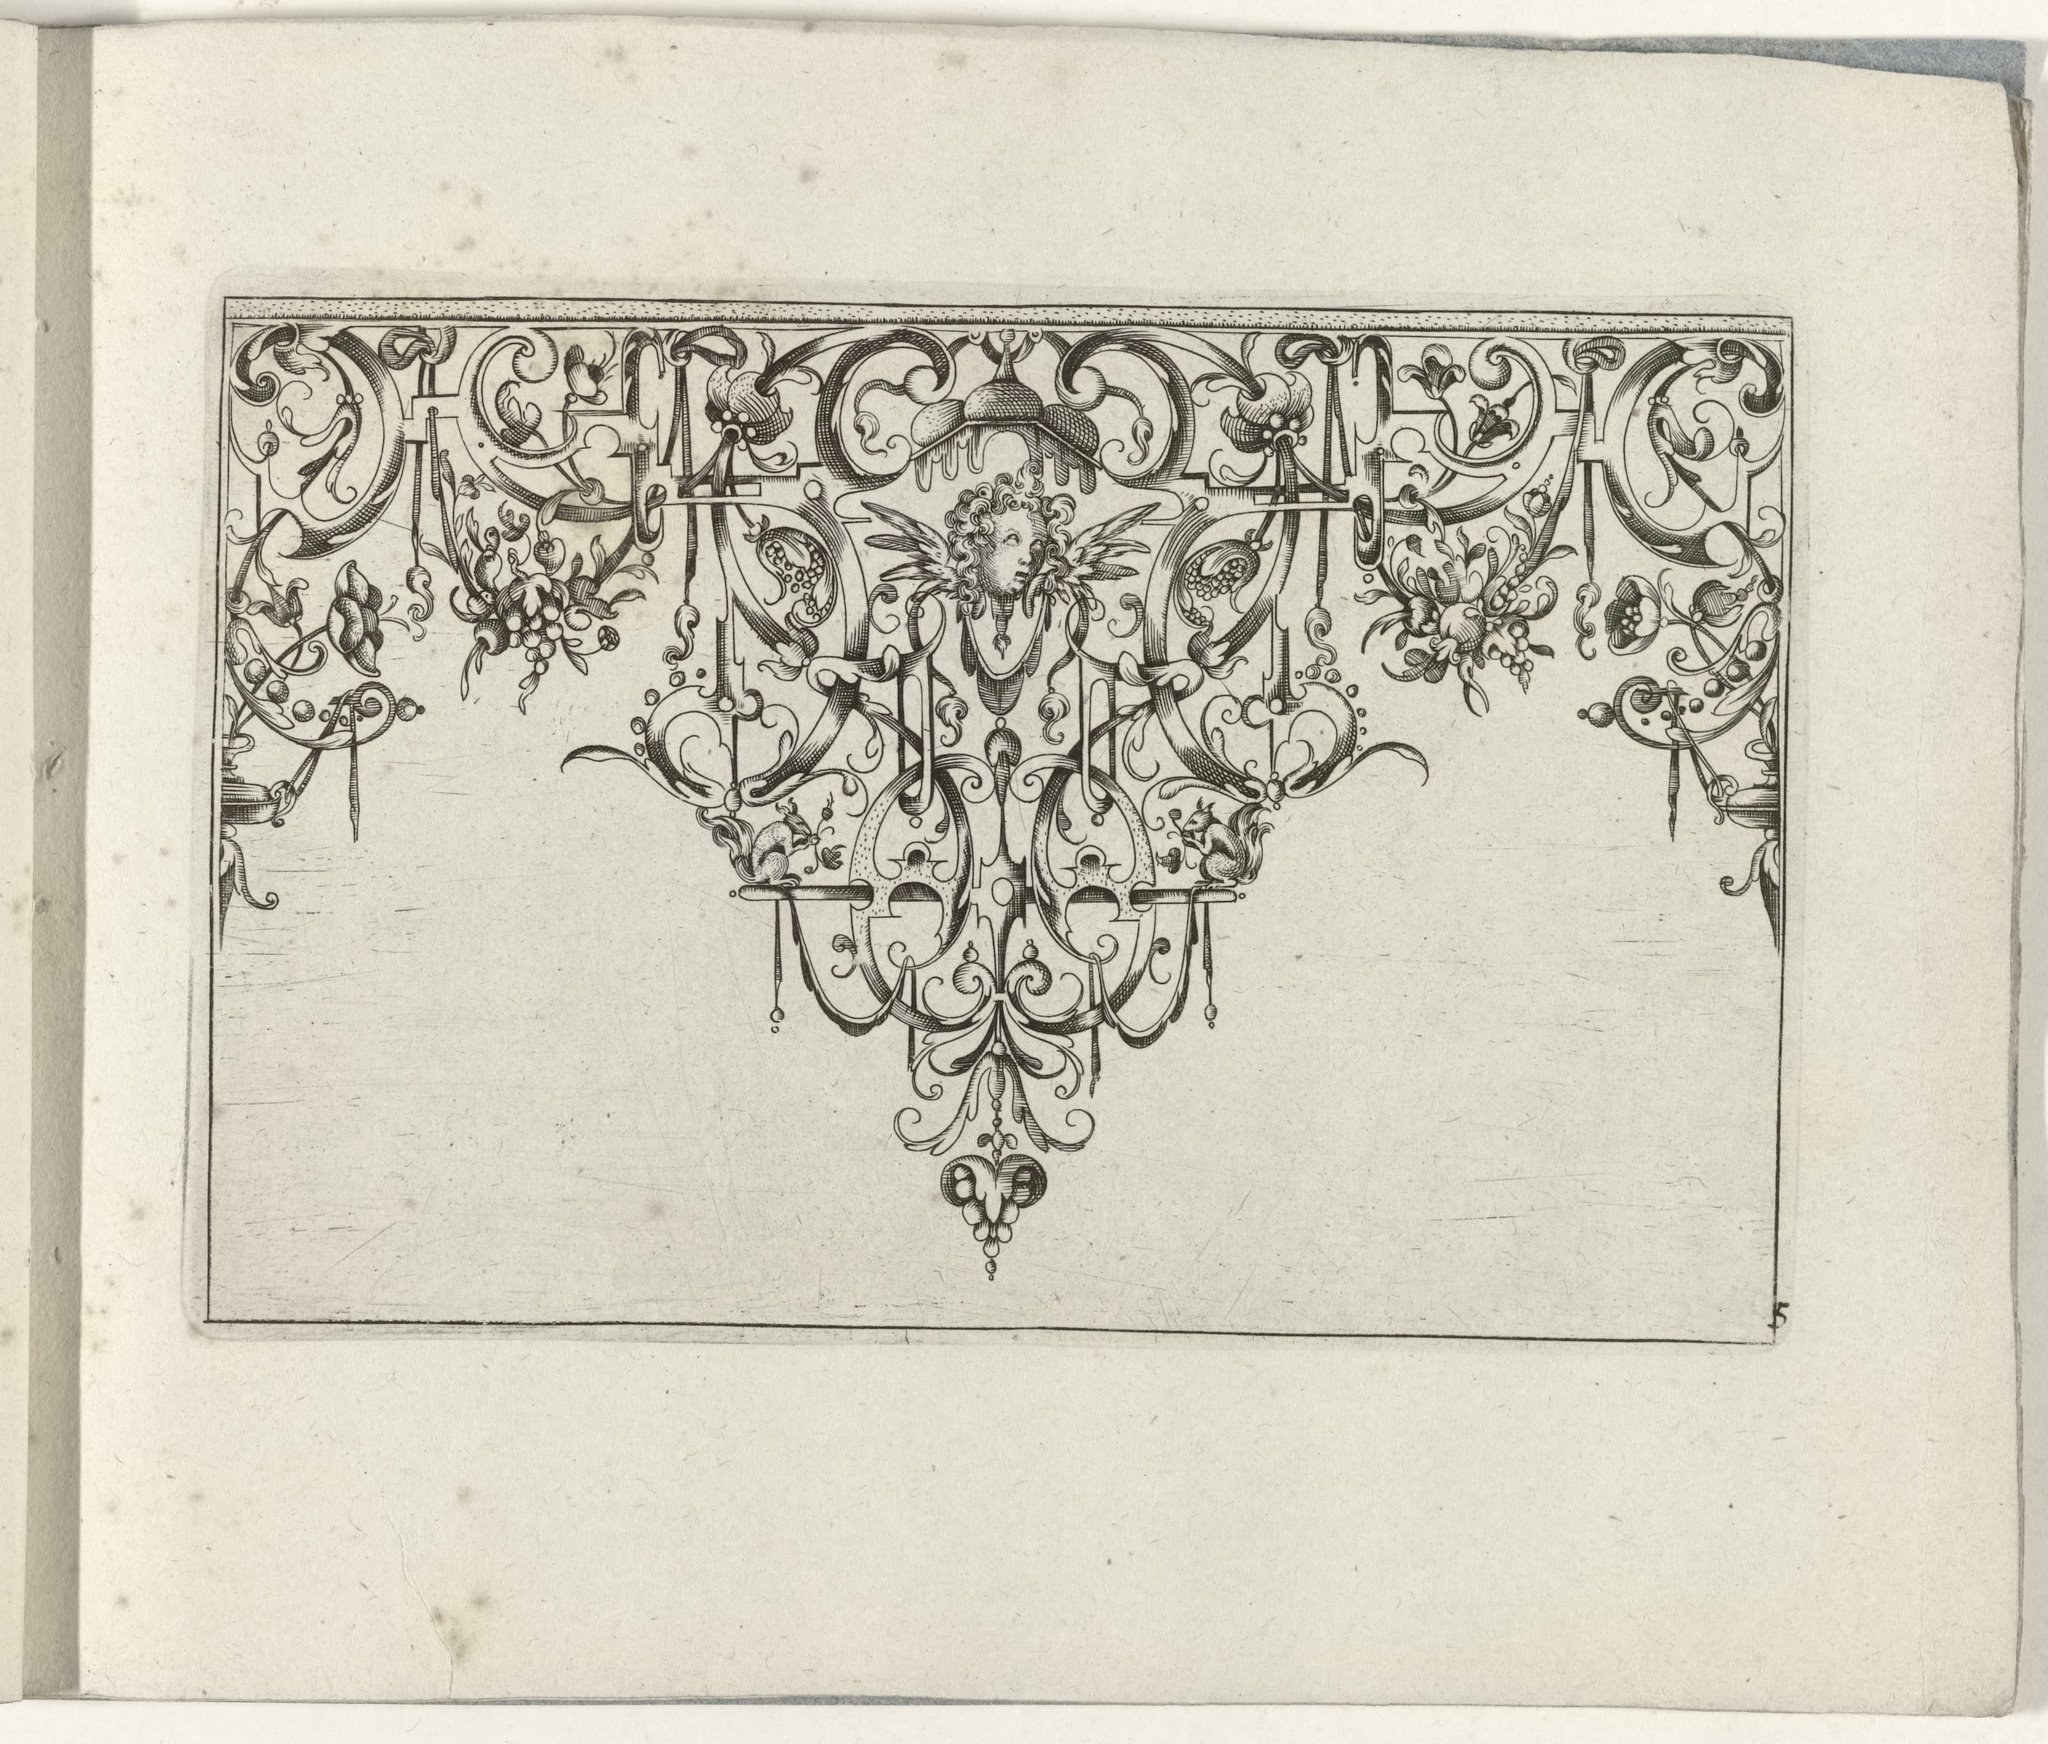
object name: ornament print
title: Spits-boeck Dienstich den Gout en Silversmeden om te Snijden en te Dryven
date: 1617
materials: paper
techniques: engraving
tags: frequently used ornamental compositions